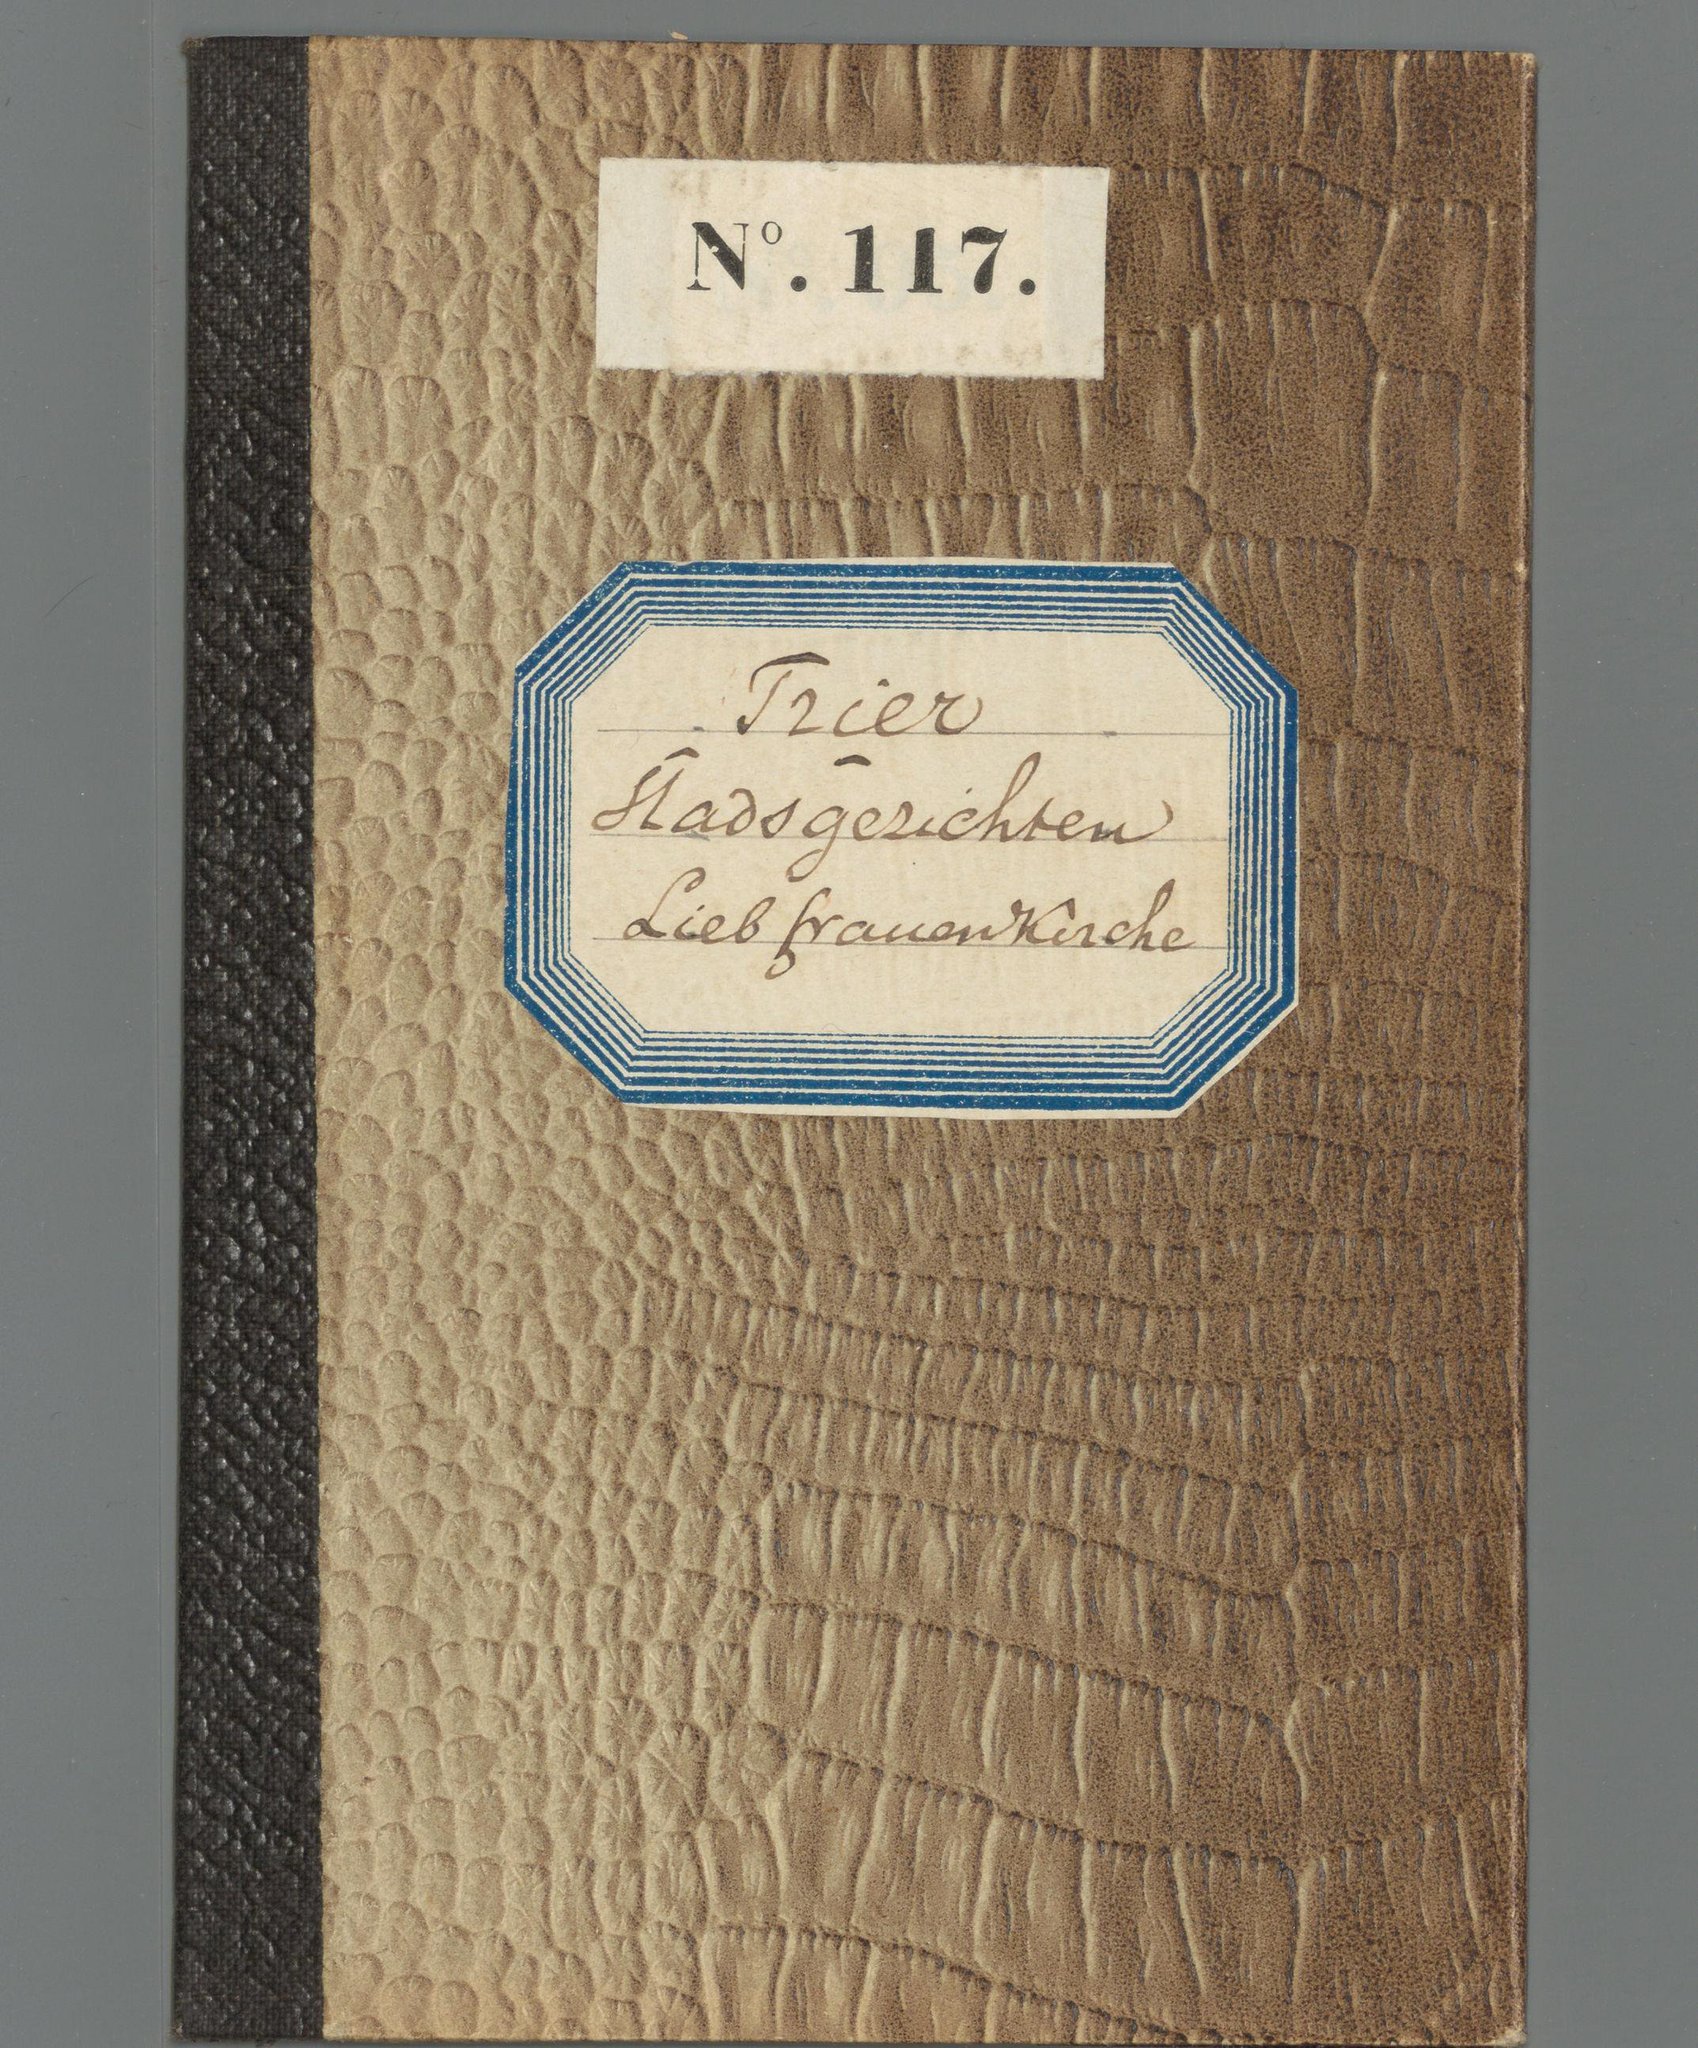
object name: wrapper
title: Omslag voor 27 prentbriefkaarten met stadsgezichten uit Trier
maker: Anonymous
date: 1900-1950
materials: cardboard, paper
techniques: lithograph, writing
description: In de omslag zit een kaart ingestoken met daarop een korte beschrijving van de inhoud.